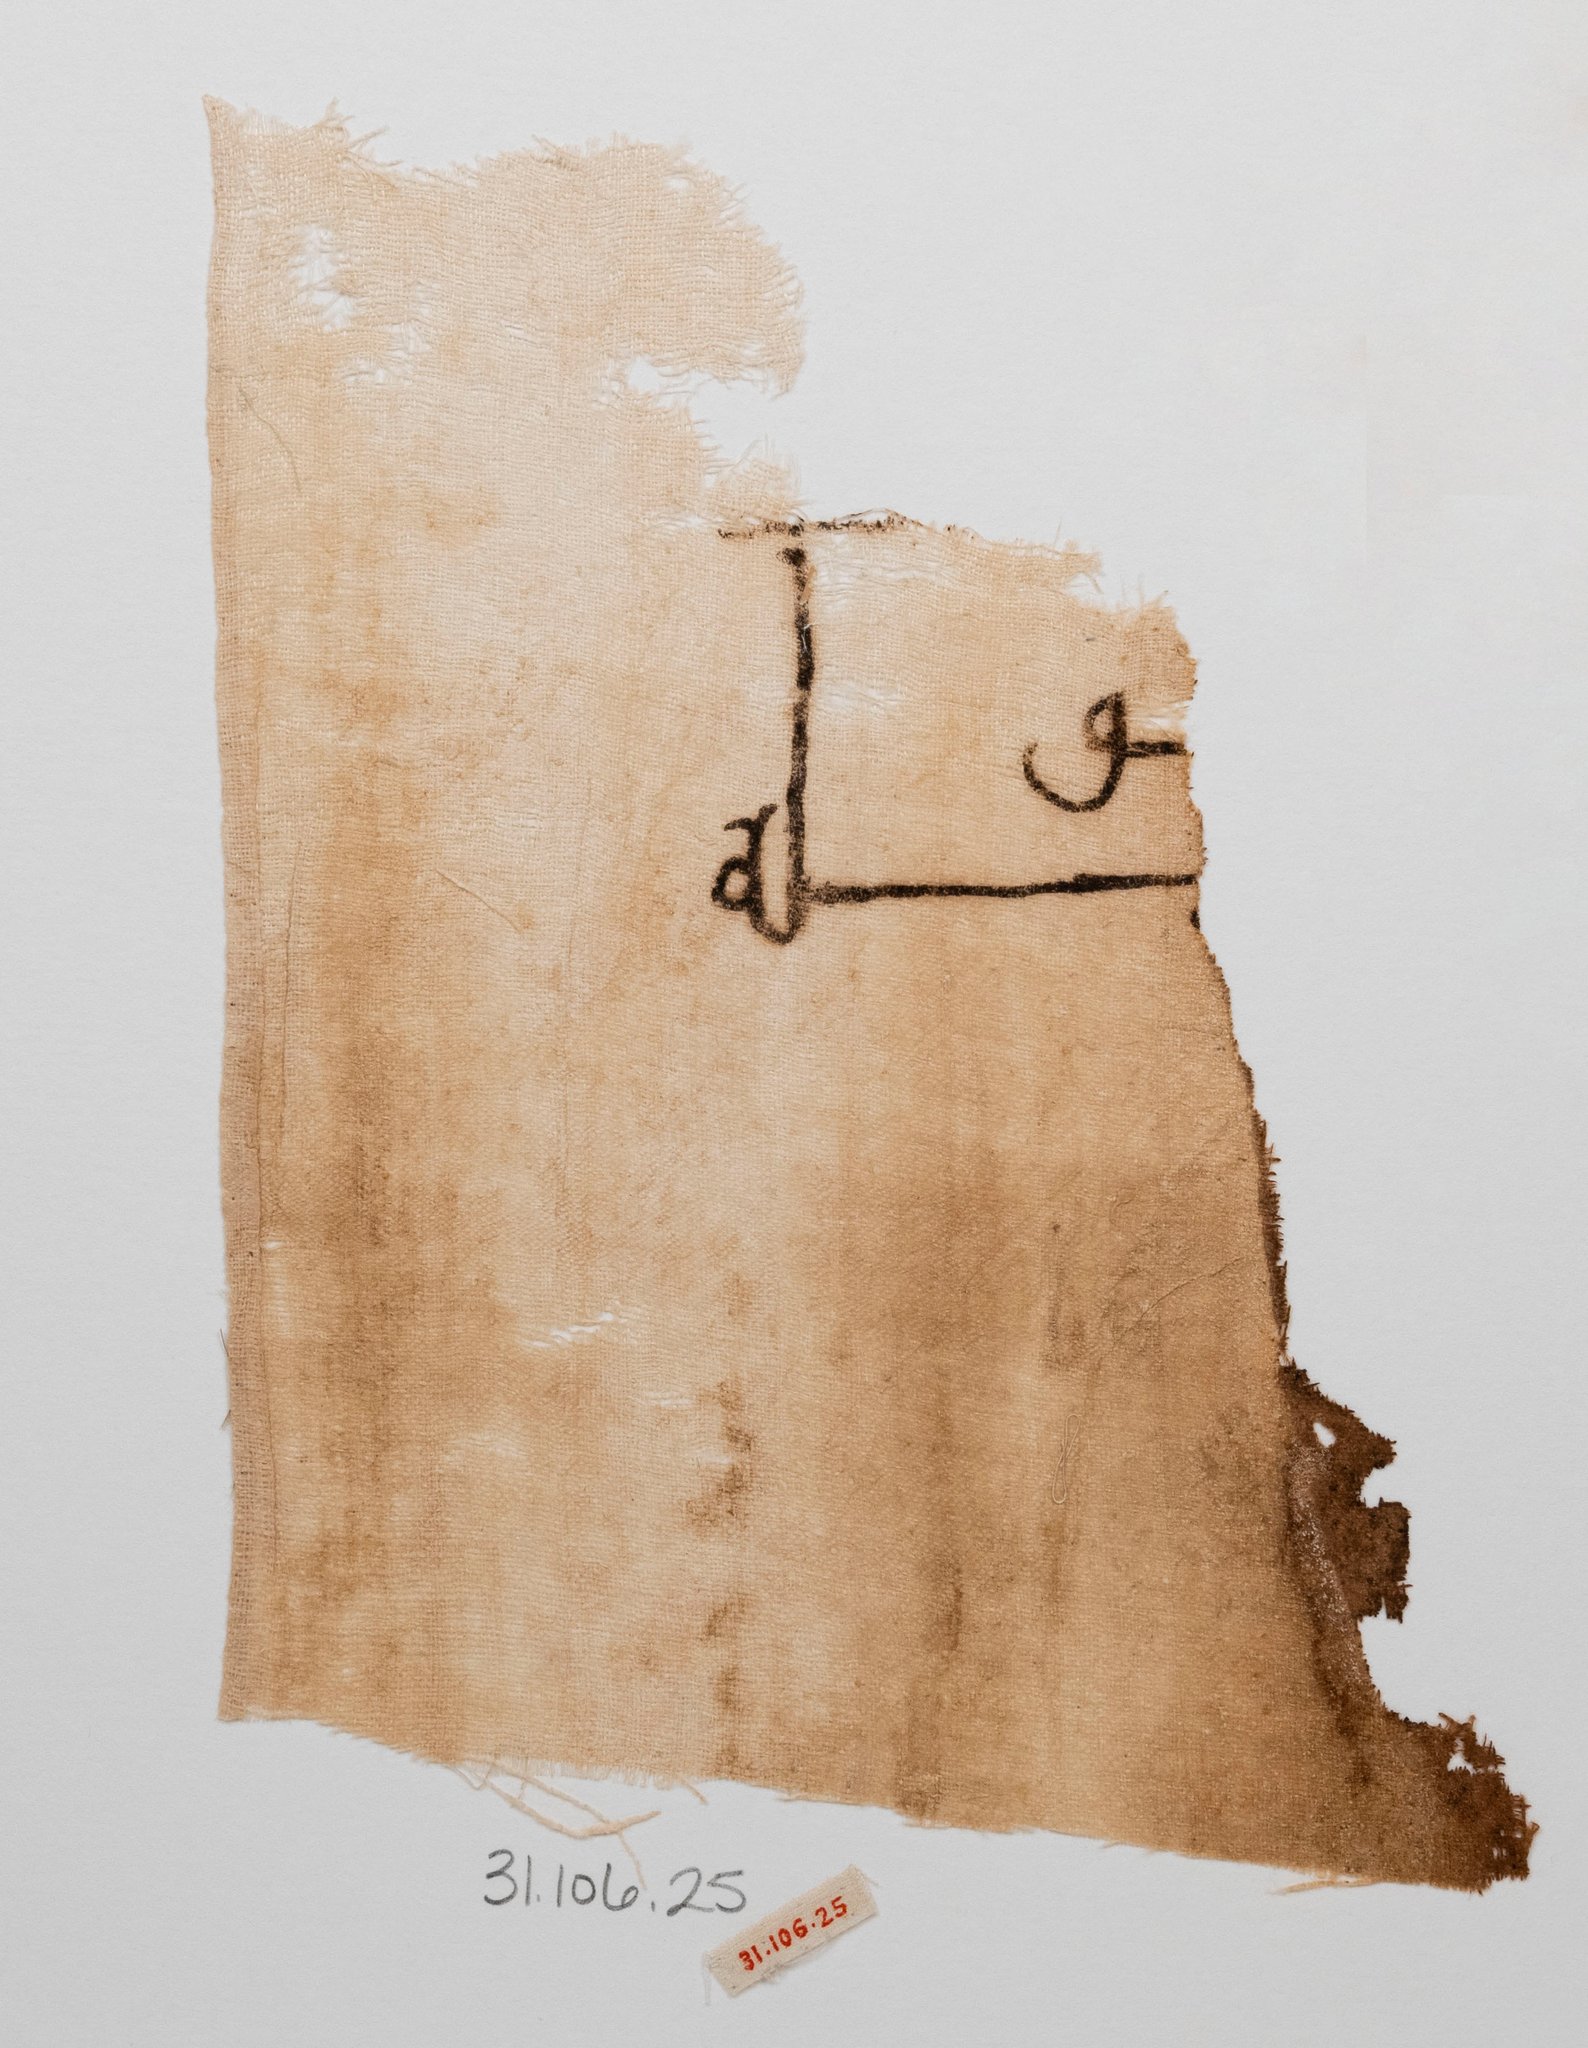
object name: textile fragment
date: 901-1000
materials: linen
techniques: painting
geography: iraq